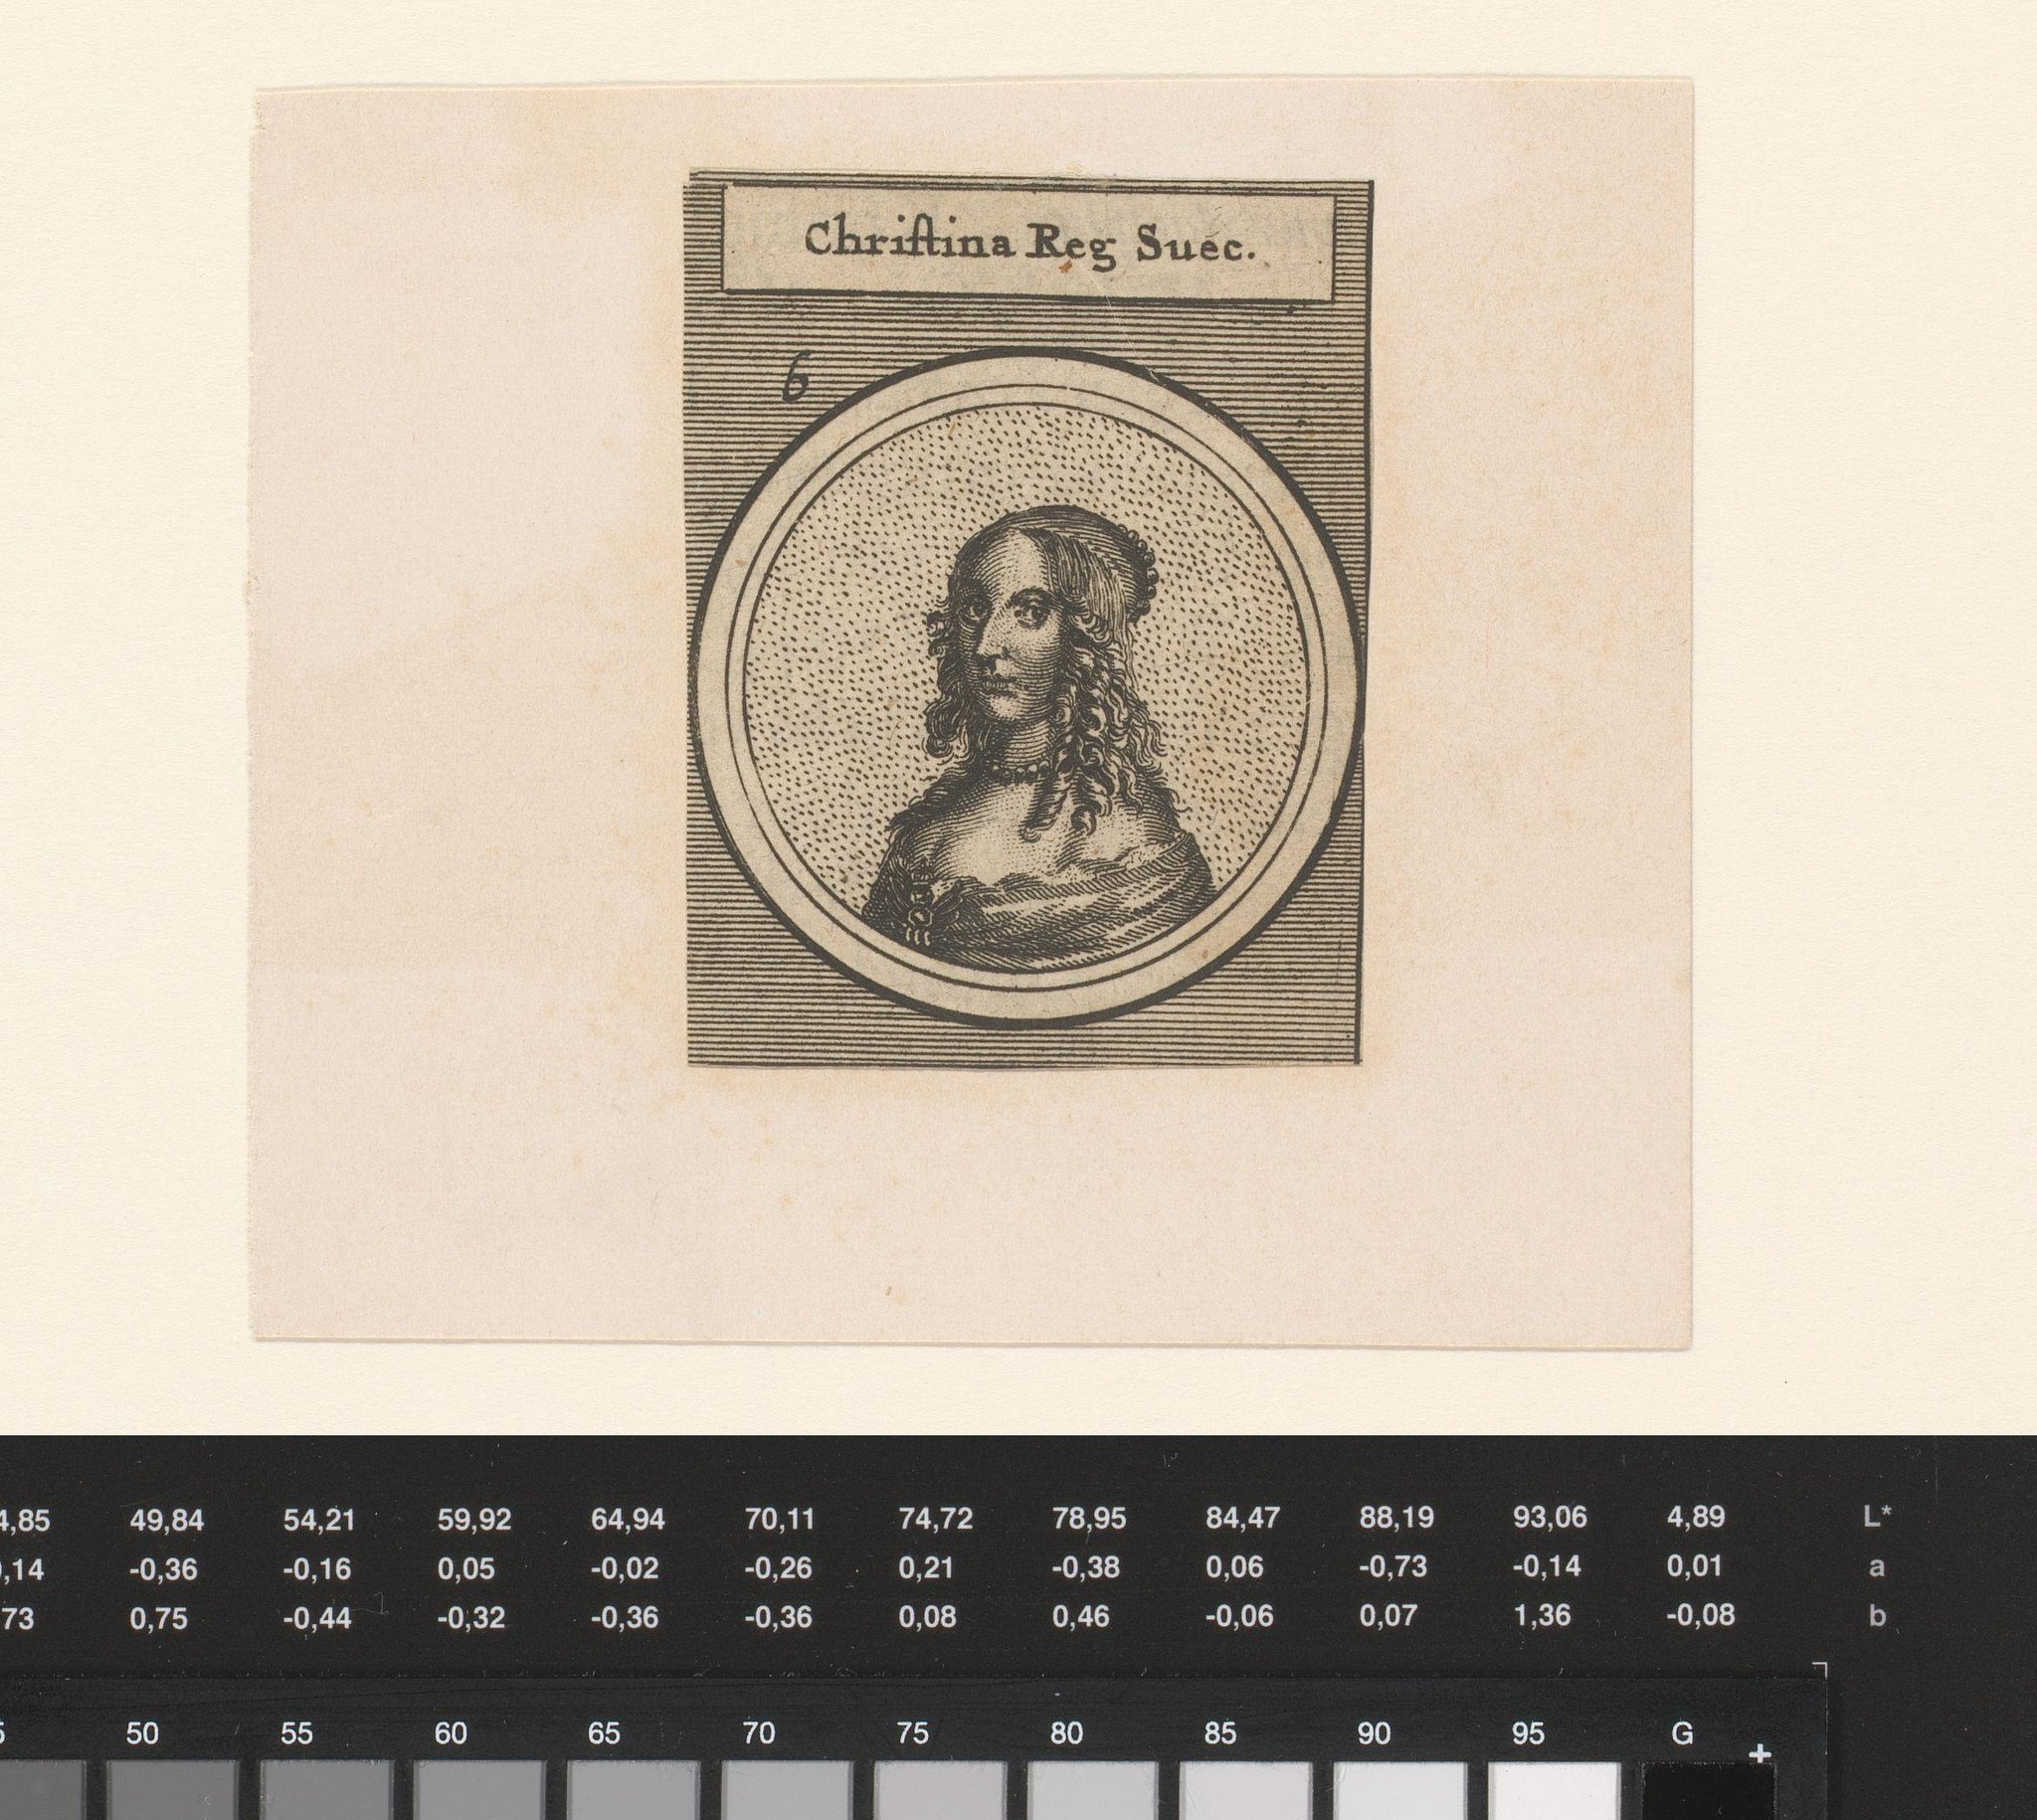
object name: print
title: Portret van Christina I van Zweden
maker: Anonymous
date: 1702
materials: paper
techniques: etching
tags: christina (koningin van zweden), historical persons - bb - woman, queen, empress, etc. (wife of a ruler)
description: Prent waarschijnlijk uit: Gottfrieds, Johann Ludwig. Historische kronyck,: vervattende een nauwkeurige en volkomene beschrijvingh der aldergedenckwaerdighste geschiedenissen des weerelds. Leiden: Pieter van der Aa, 1702.